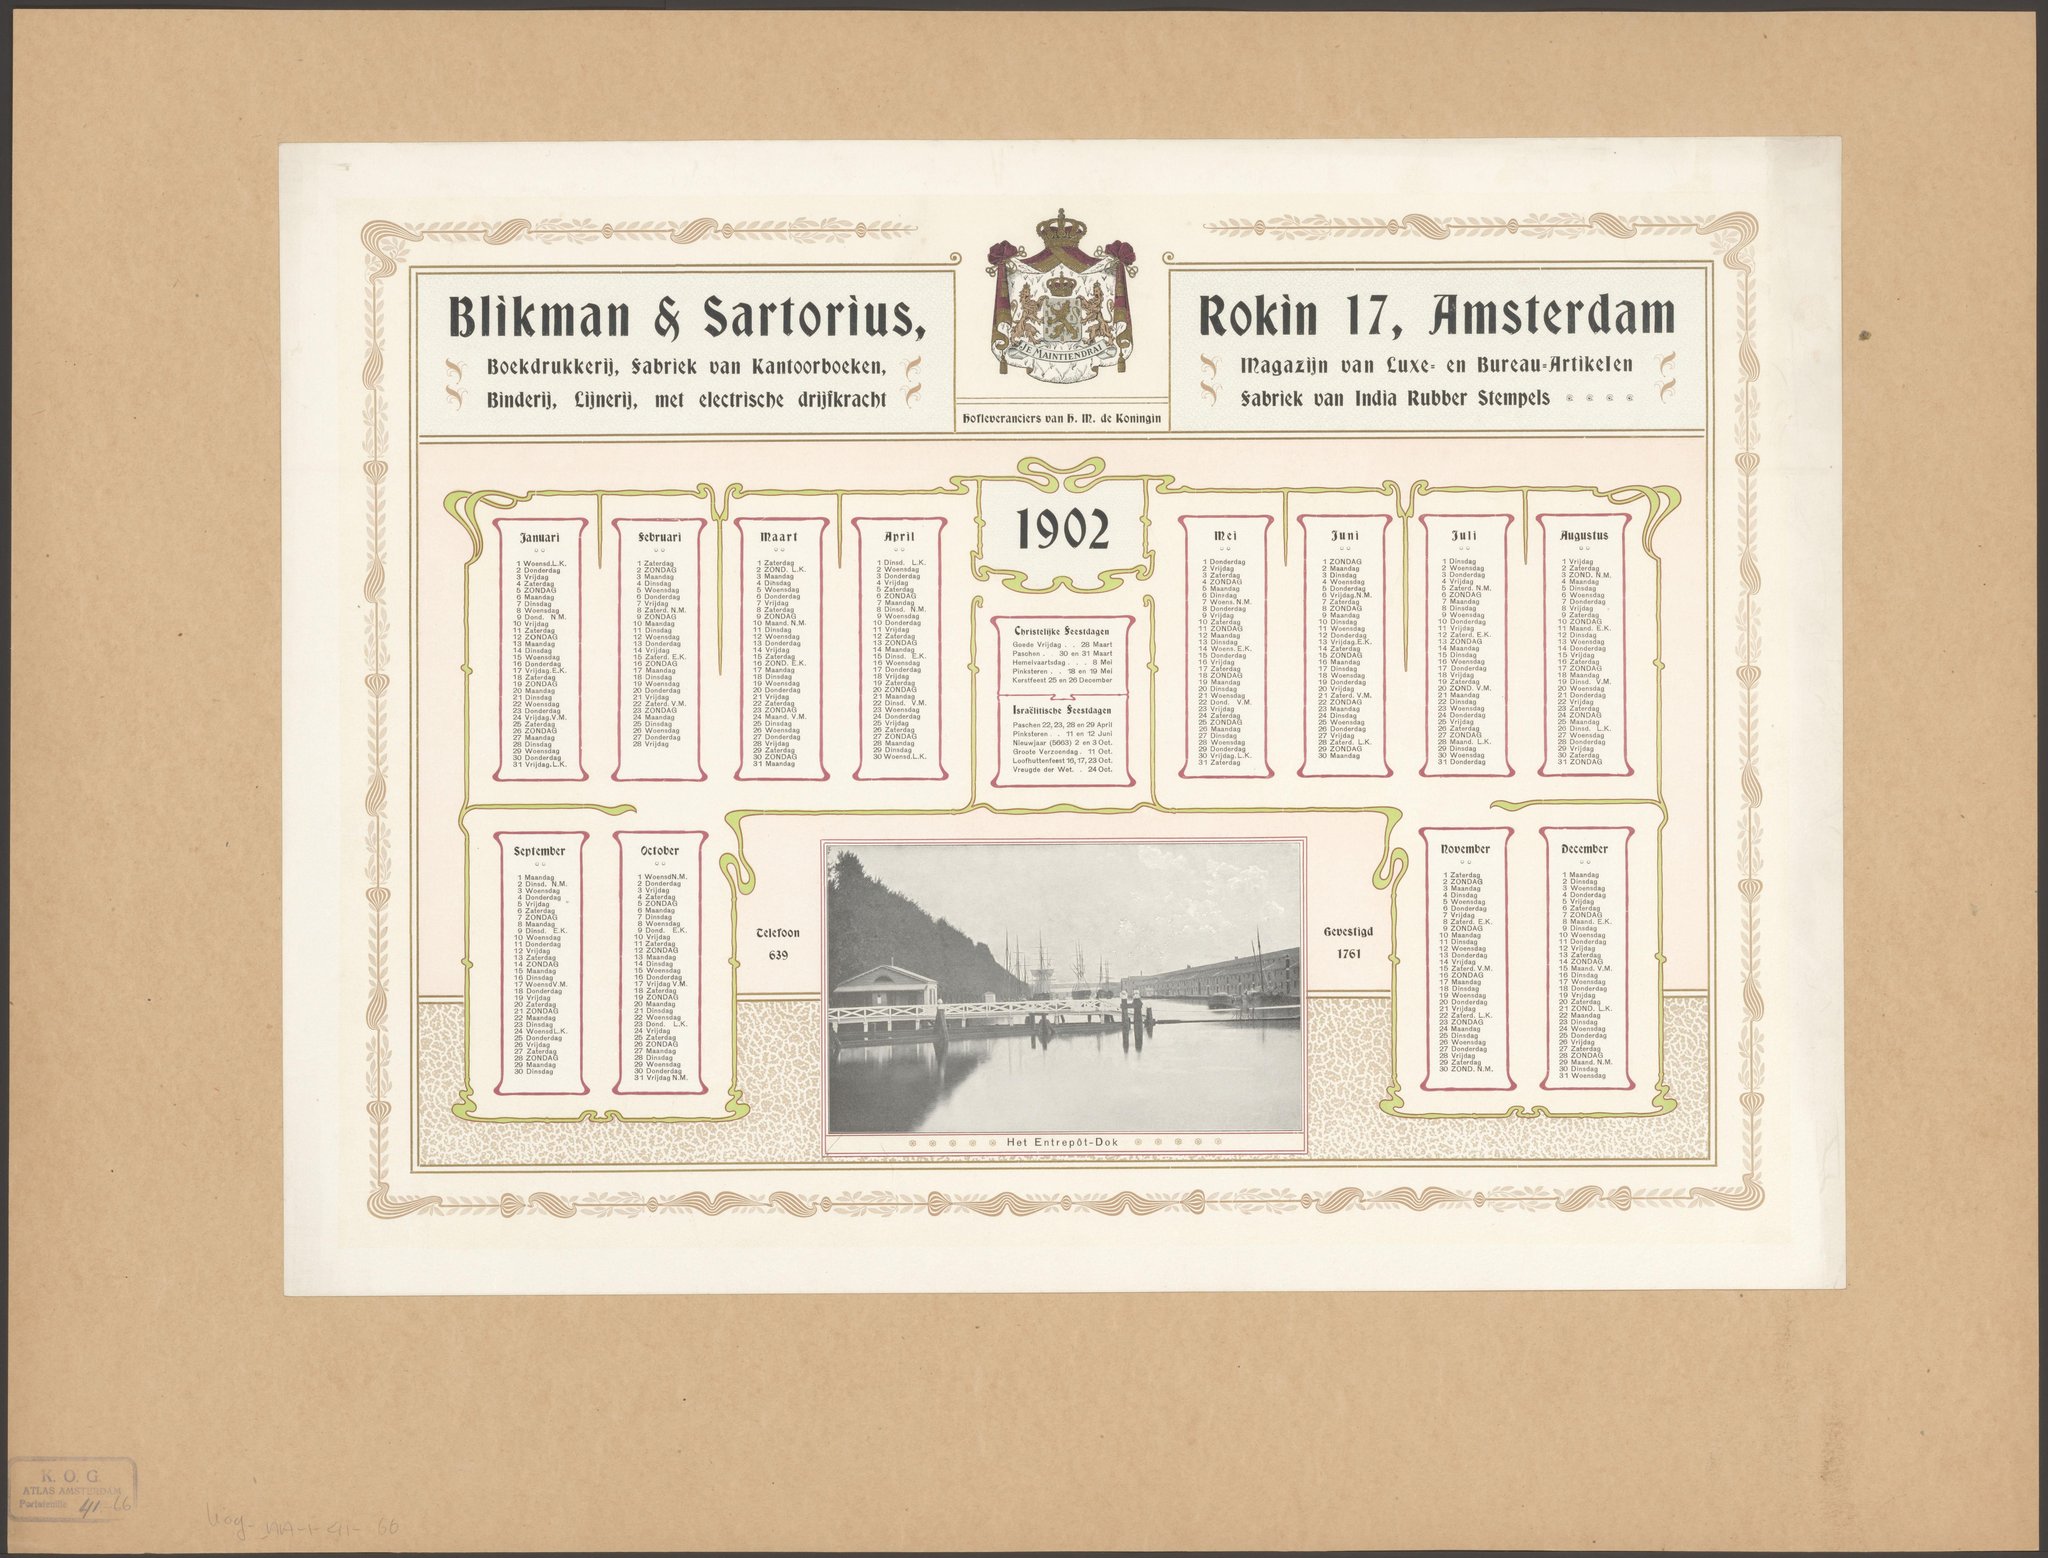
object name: calendar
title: Kalender voor het jaar 1902 met gezicht op het Entrepotdok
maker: Anonymous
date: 1902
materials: paper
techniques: lithograph, line block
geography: amsterdam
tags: harbour, city-view in general; 'veduta', canal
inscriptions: collector's mark: ‘41-66’ Lugt 1641b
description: Onderwerpsrubriek binnen de Atlas Amsterdam: Entrepot.